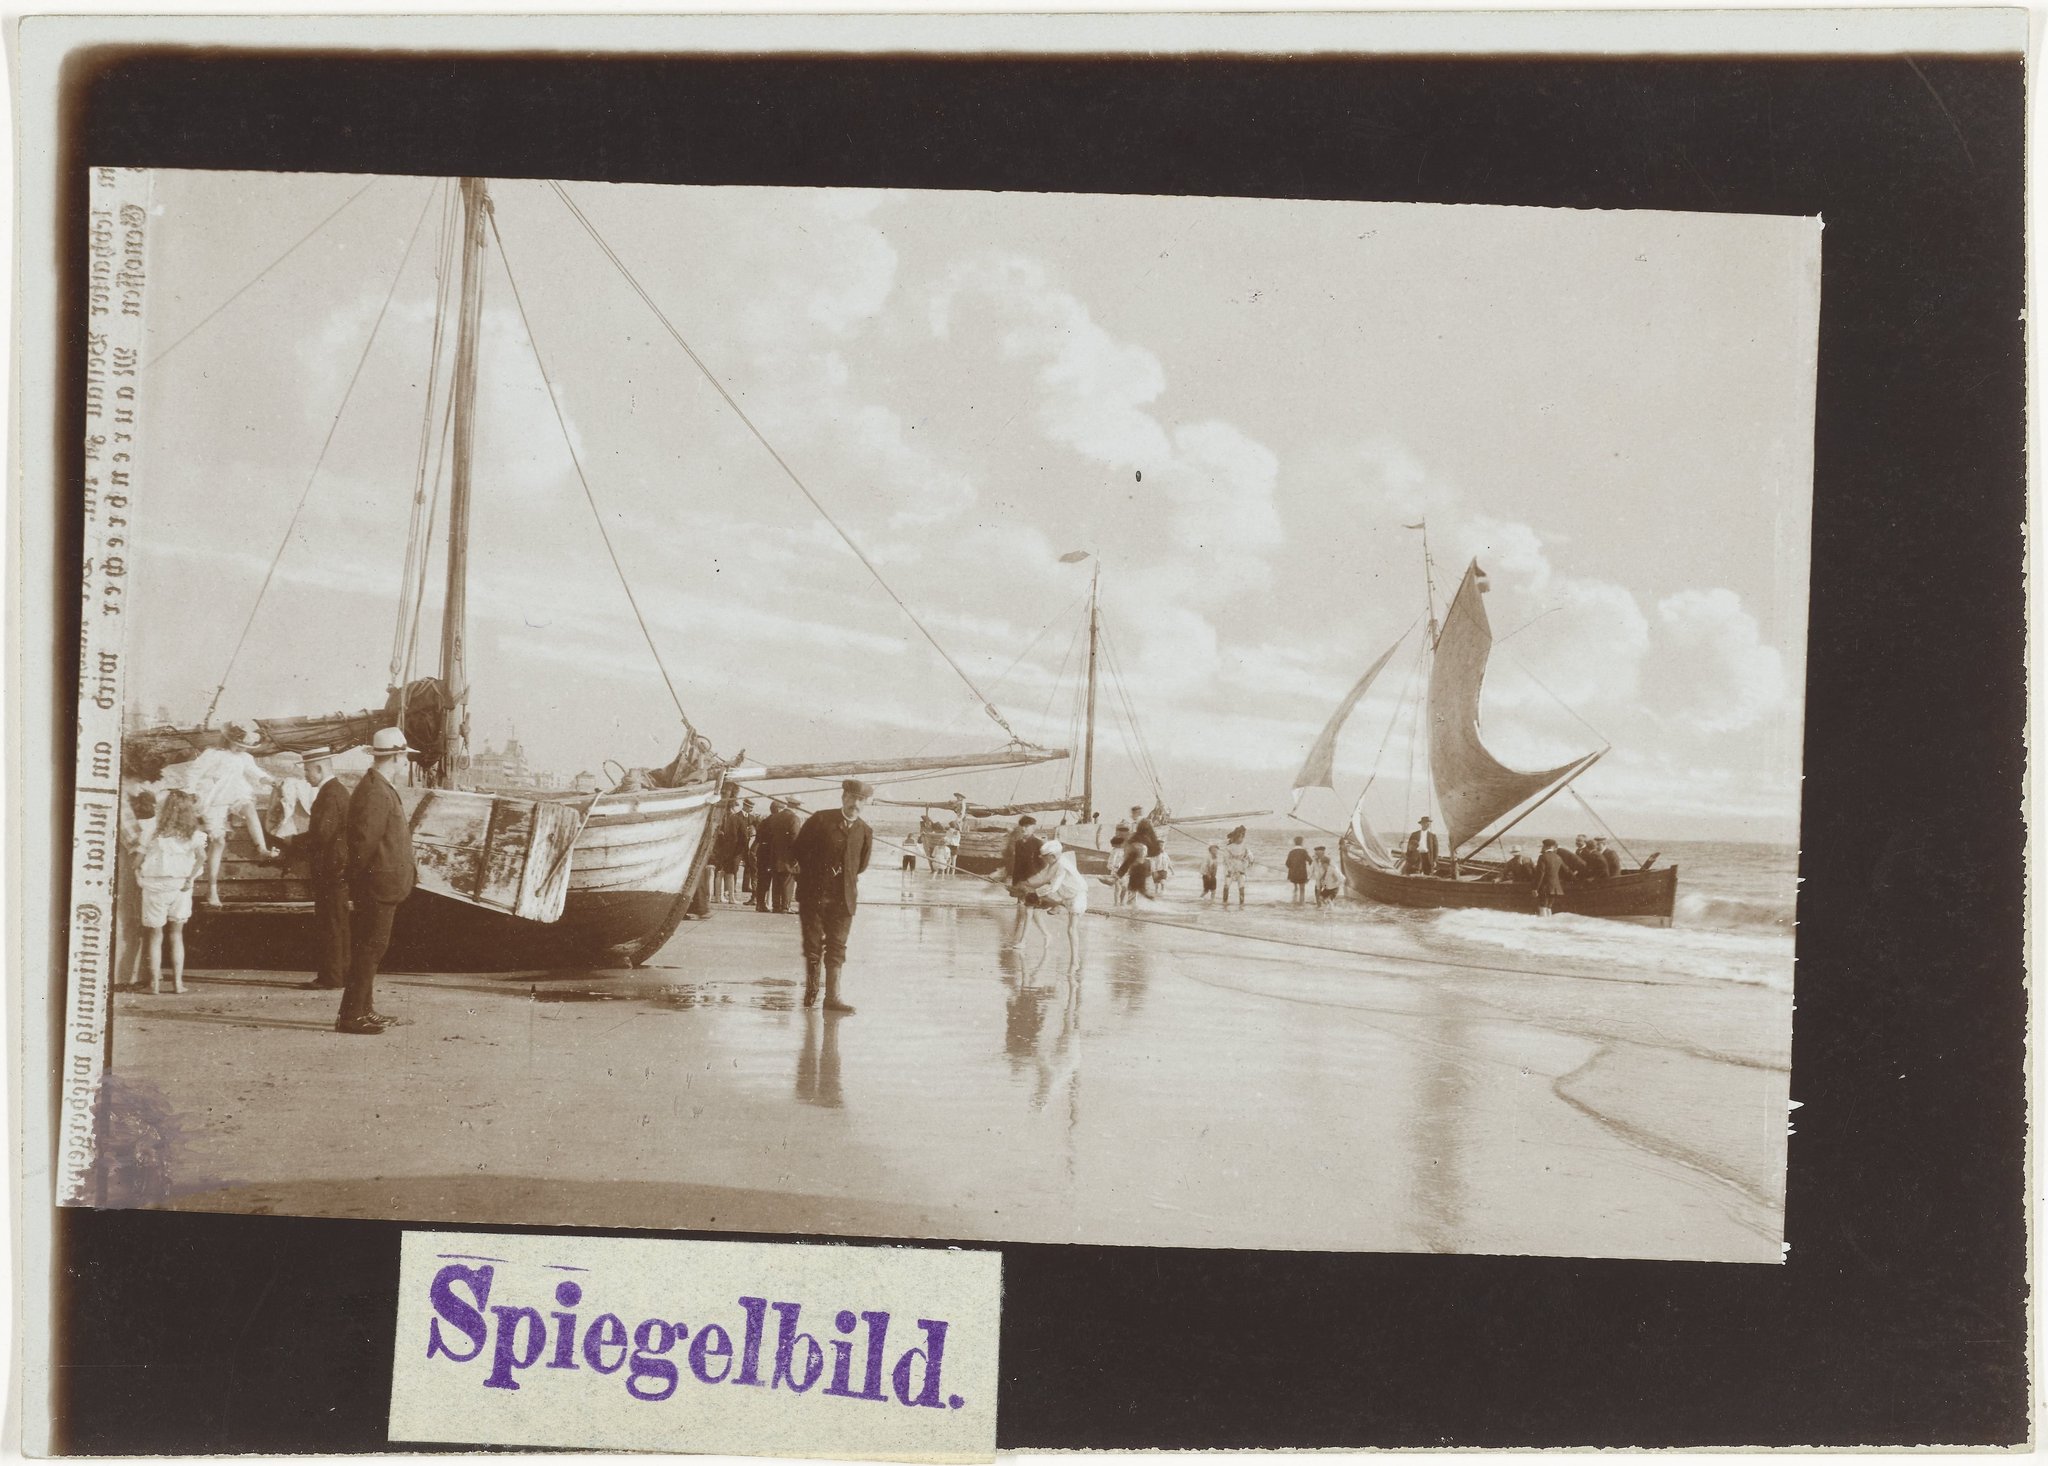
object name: photograph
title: Vissersboten op het strand in Zandvoort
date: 1900-1905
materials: photographic support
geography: zandvoort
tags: beach (as place of recreation)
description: Vissersboten op het strand. M.o. opschrift 'Spiegelbild'.